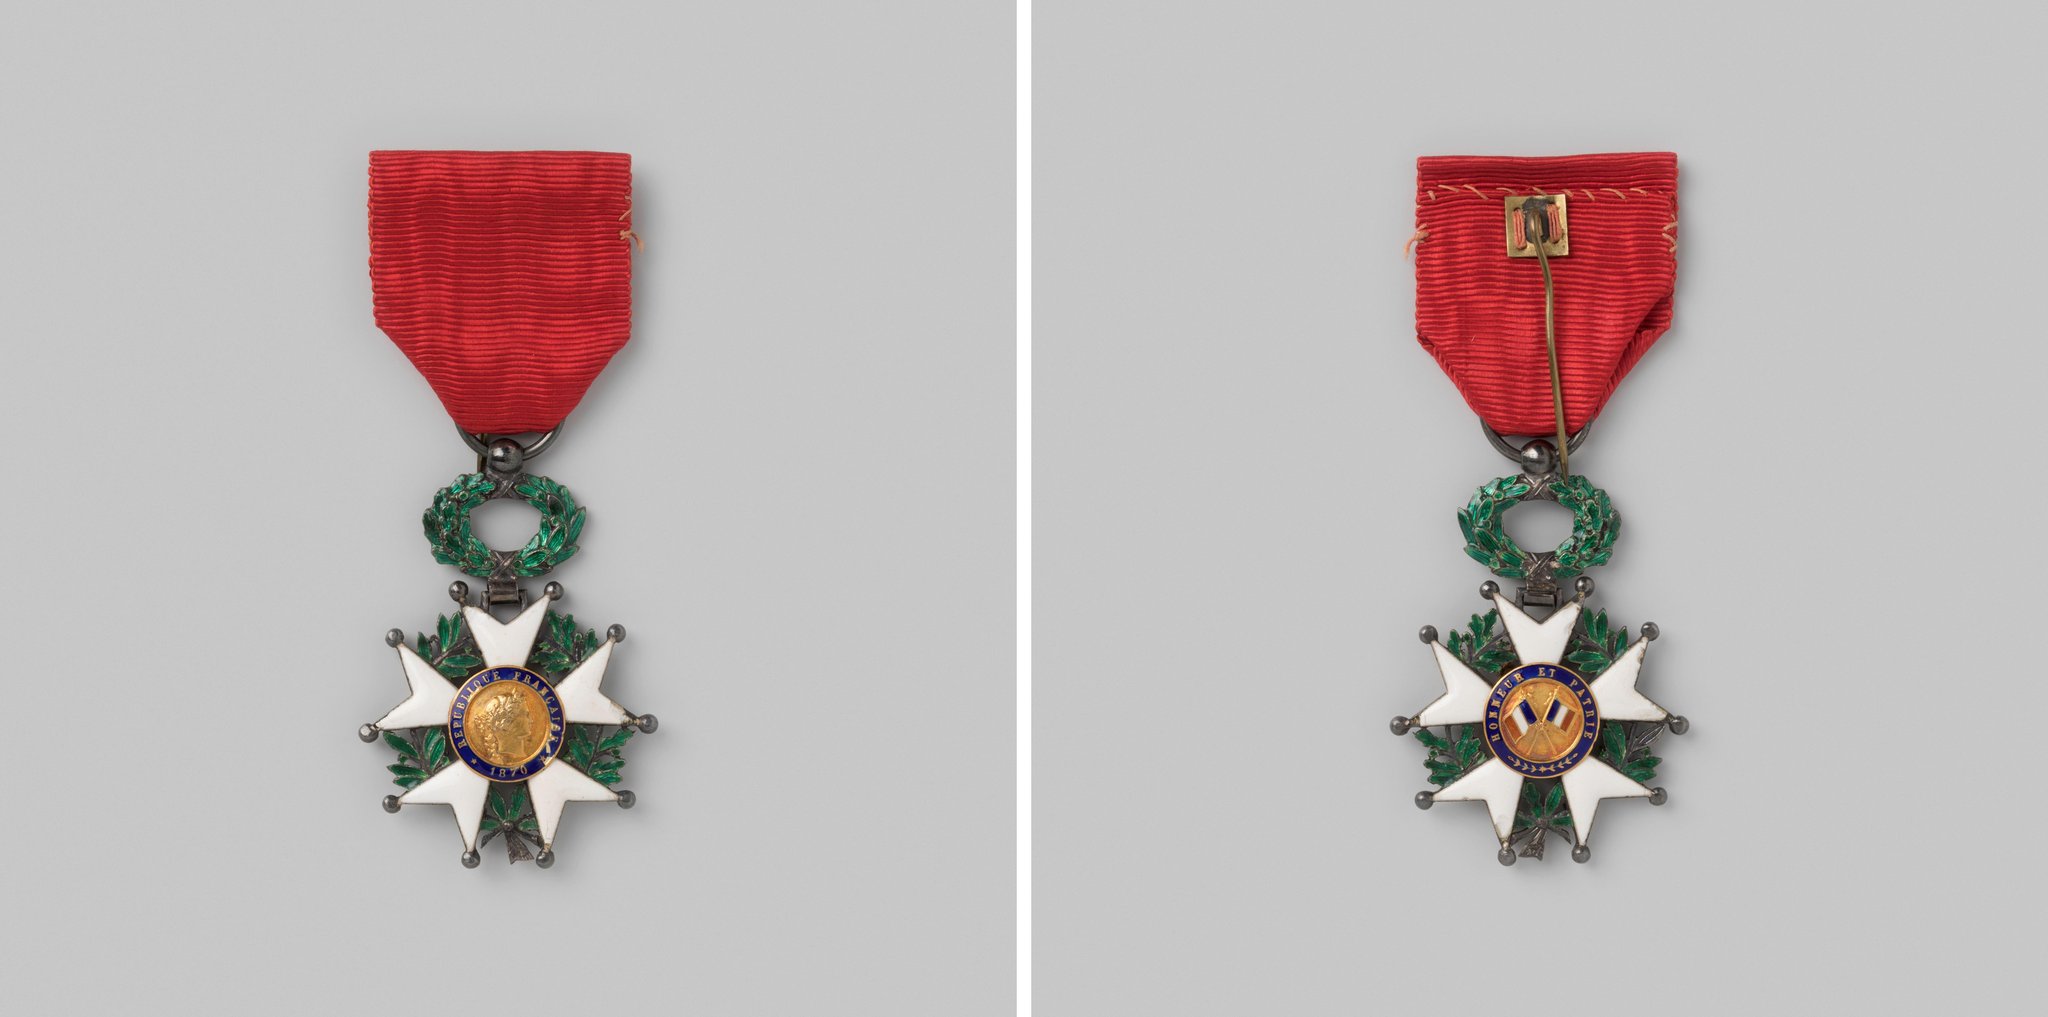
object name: onderscheidingsteken, onderscheiding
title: Orde van het Legioen van Eer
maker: Anonymous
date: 1870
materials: metal, textile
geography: france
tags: the hague, amsterdam, sculptor, bart van hove, france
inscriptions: inscription: ‘REPUBLIQUE FRANÇAISE 1870’, inscription: ‘HONNEUR ET PATRIE’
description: Onderscheiding met witte emaillen ster van vijf stralen, ieder eindigend in twee punten met een rond bolletje, op een groene krans. Hierboven een groene krans, een ring waaraan een rood lint waaraan een speld. In het midden van de ster Voorzijde: een goudkleurige medaillon met een vrouwenhoofd met profiel naar rechts waaromheen een blauwe rand met goudkleurig omschrift. Keerzijde: een goudkleurig medaillon met twee gekruiste Franse vlaggen waaromheen een blauwe rand met goudkleurig omschrift.